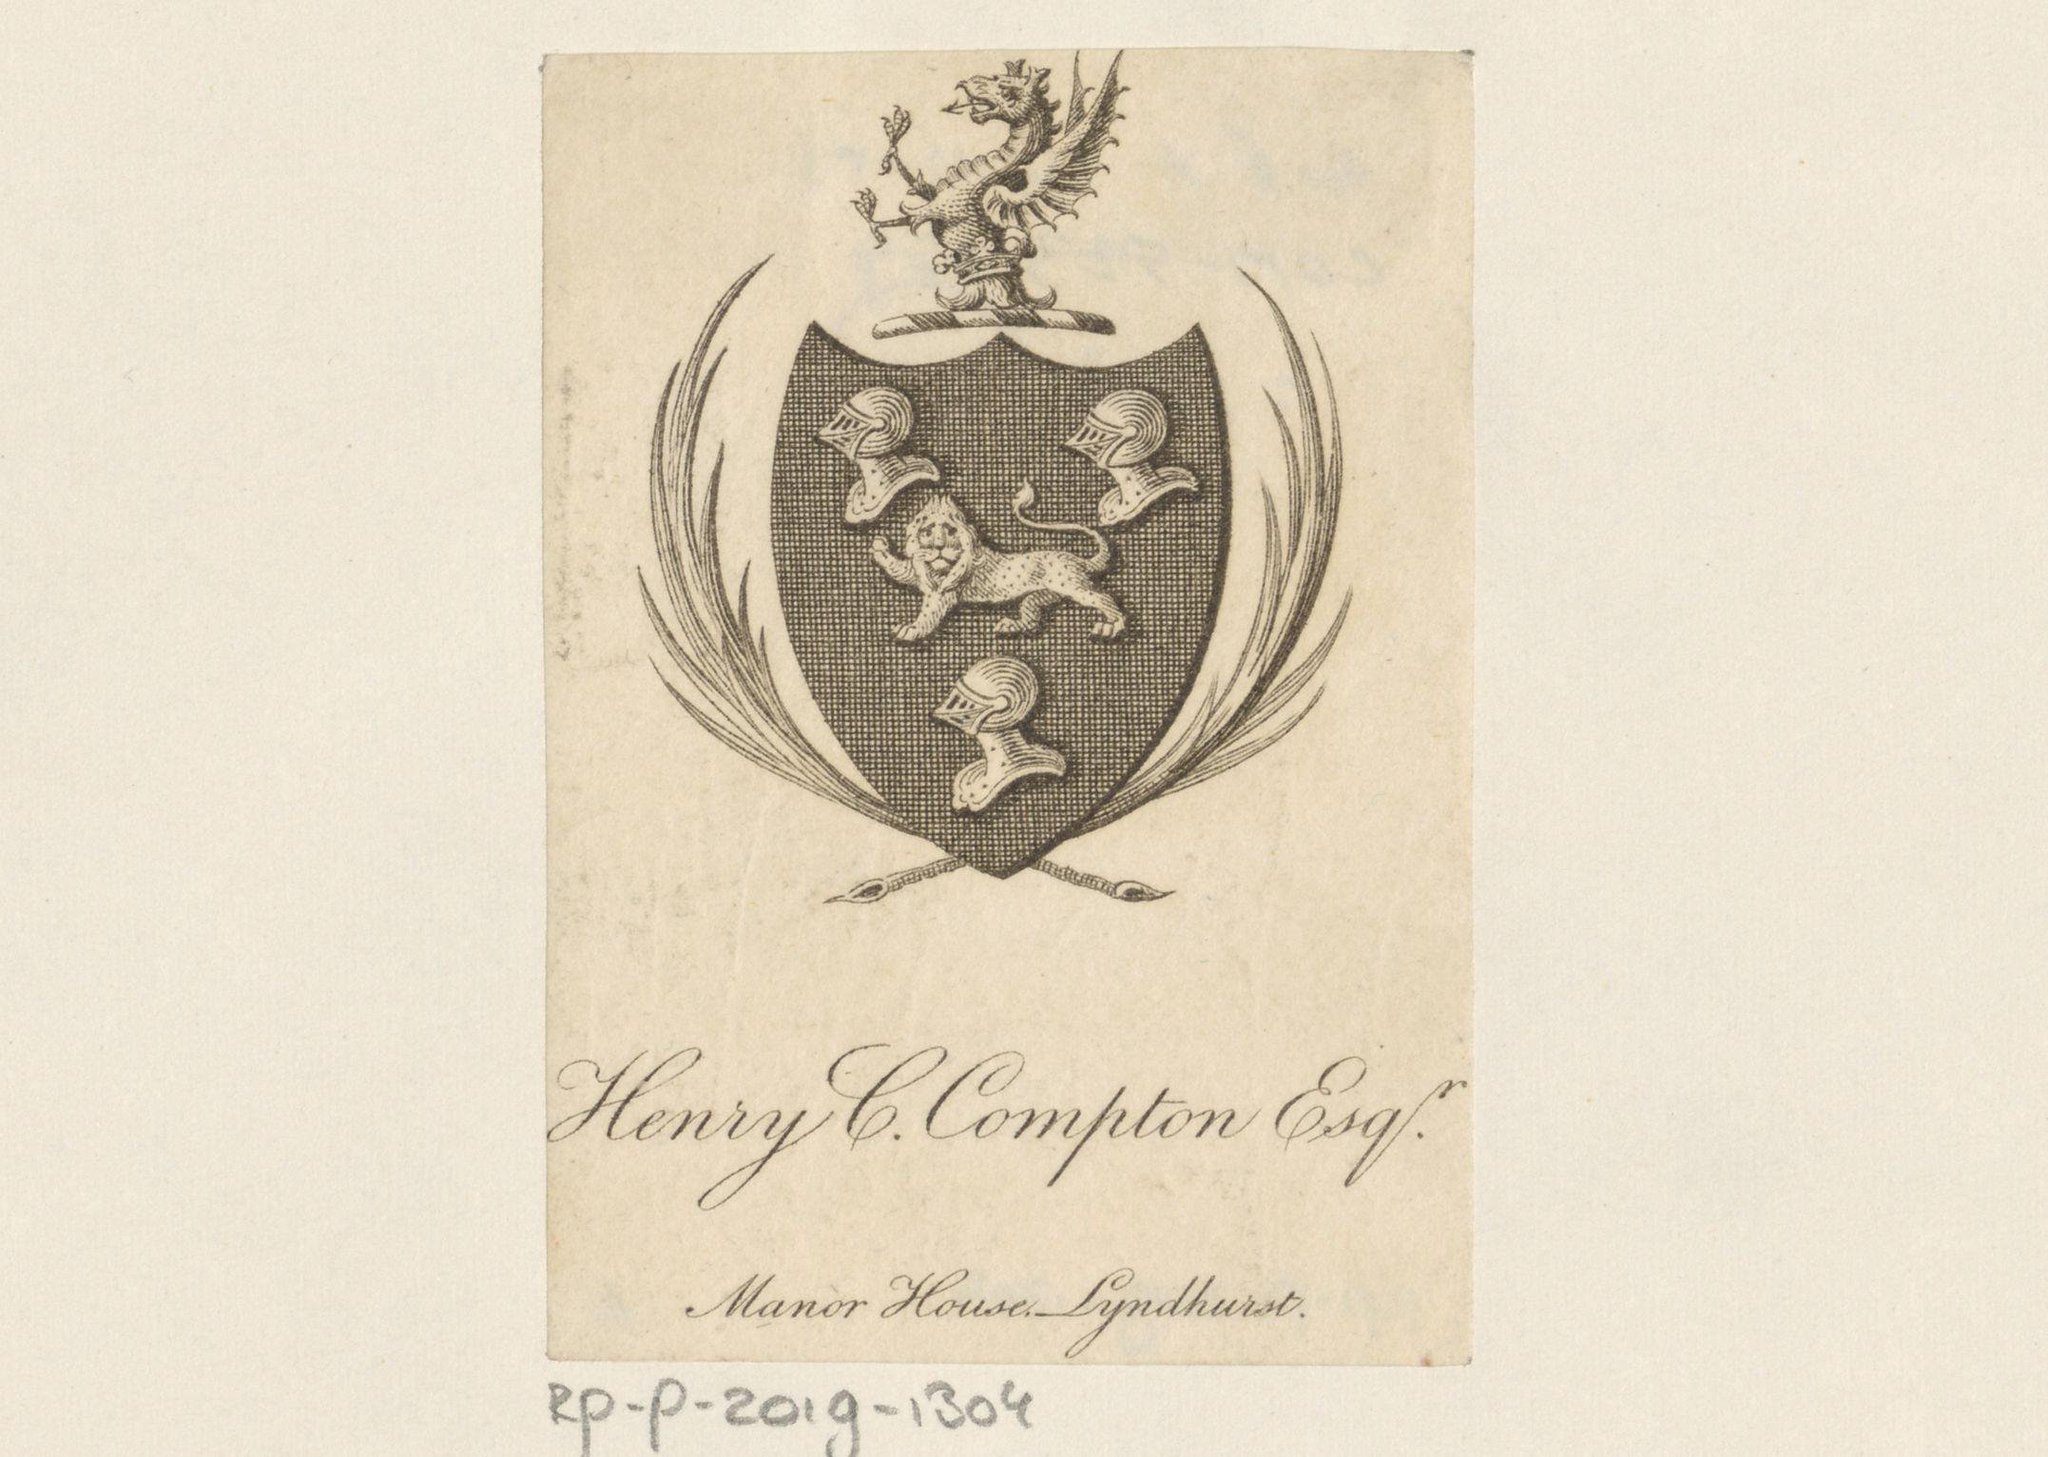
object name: bookplate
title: Ex libris van Henry C. Compton Esqr.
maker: Anonymous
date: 1799-1866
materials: paper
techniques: engraving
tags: armorial bearing, heraldry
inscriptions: collector's mark: ‘B.K.’